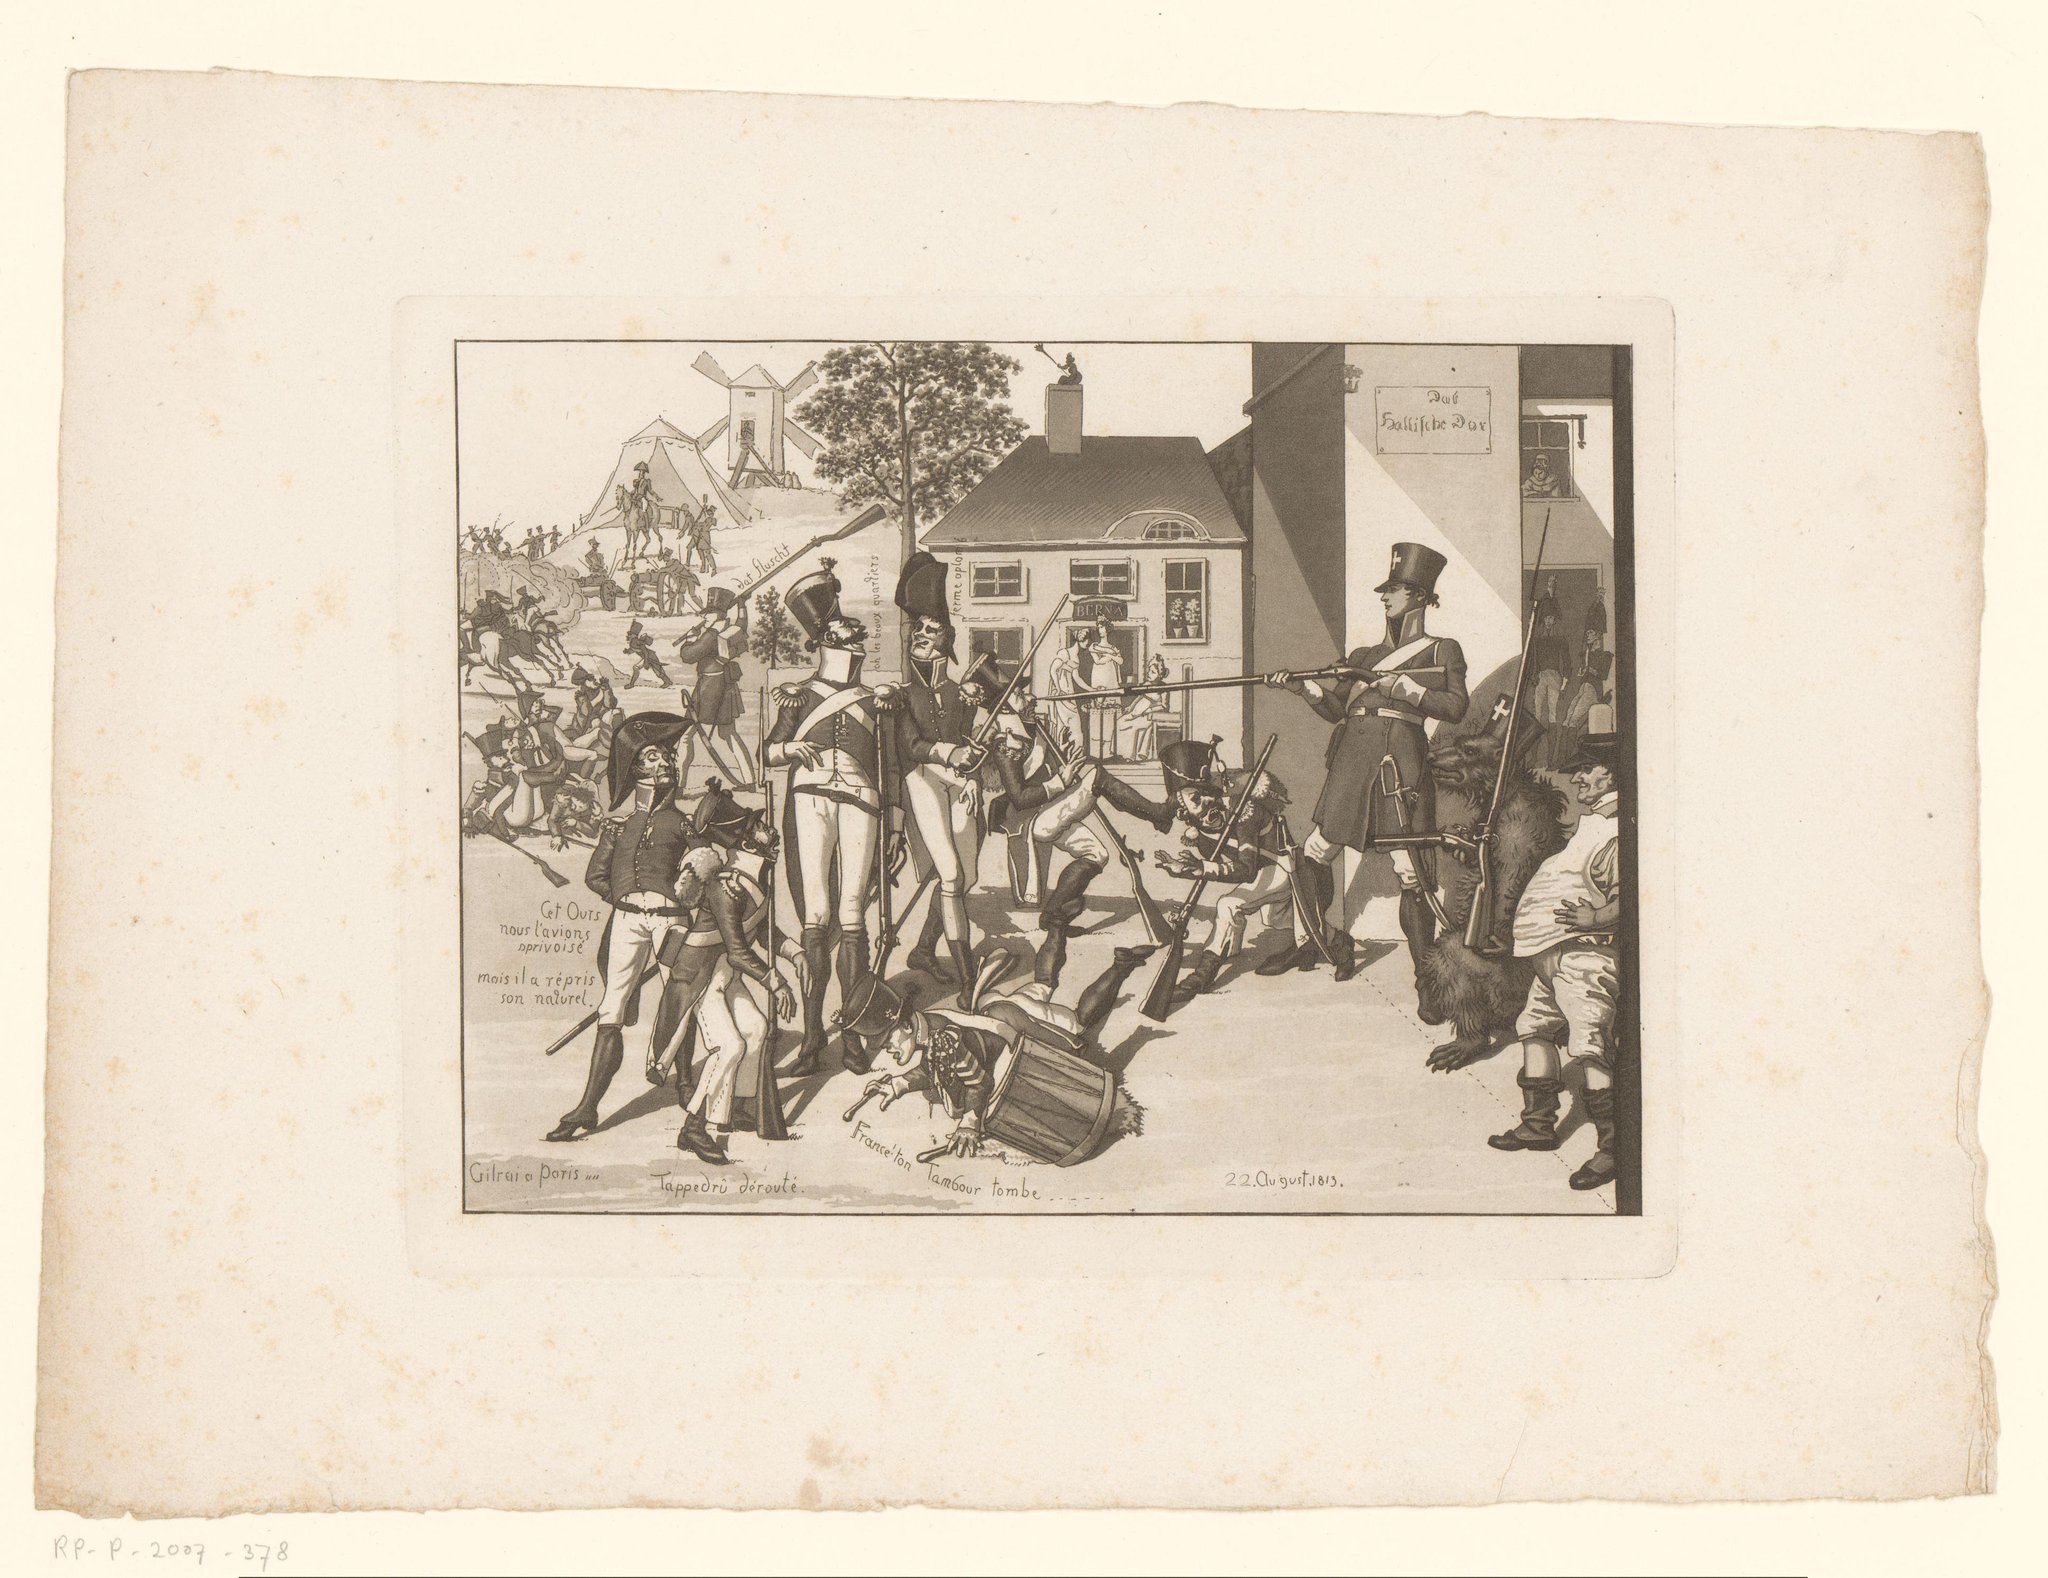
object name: print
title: Das Hallische Tor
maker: gottfried schadow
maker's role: print maker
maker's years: 1764-1850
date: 1815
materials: paper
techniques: aquatint, etching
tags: political caricatures and satires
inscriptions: collector's mark: Lugt 2760, collector's mark: Lugt 2228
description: Enige Franse soldaten staan voor de Hallische Tor die met succes wordt verdedigd door een beer en nog twee figuren. Op de achtergrond Napoleon te paard bij een legertent en vluchtende ruiters. Tussen de figuren Franse teksten en "22. August 1813".